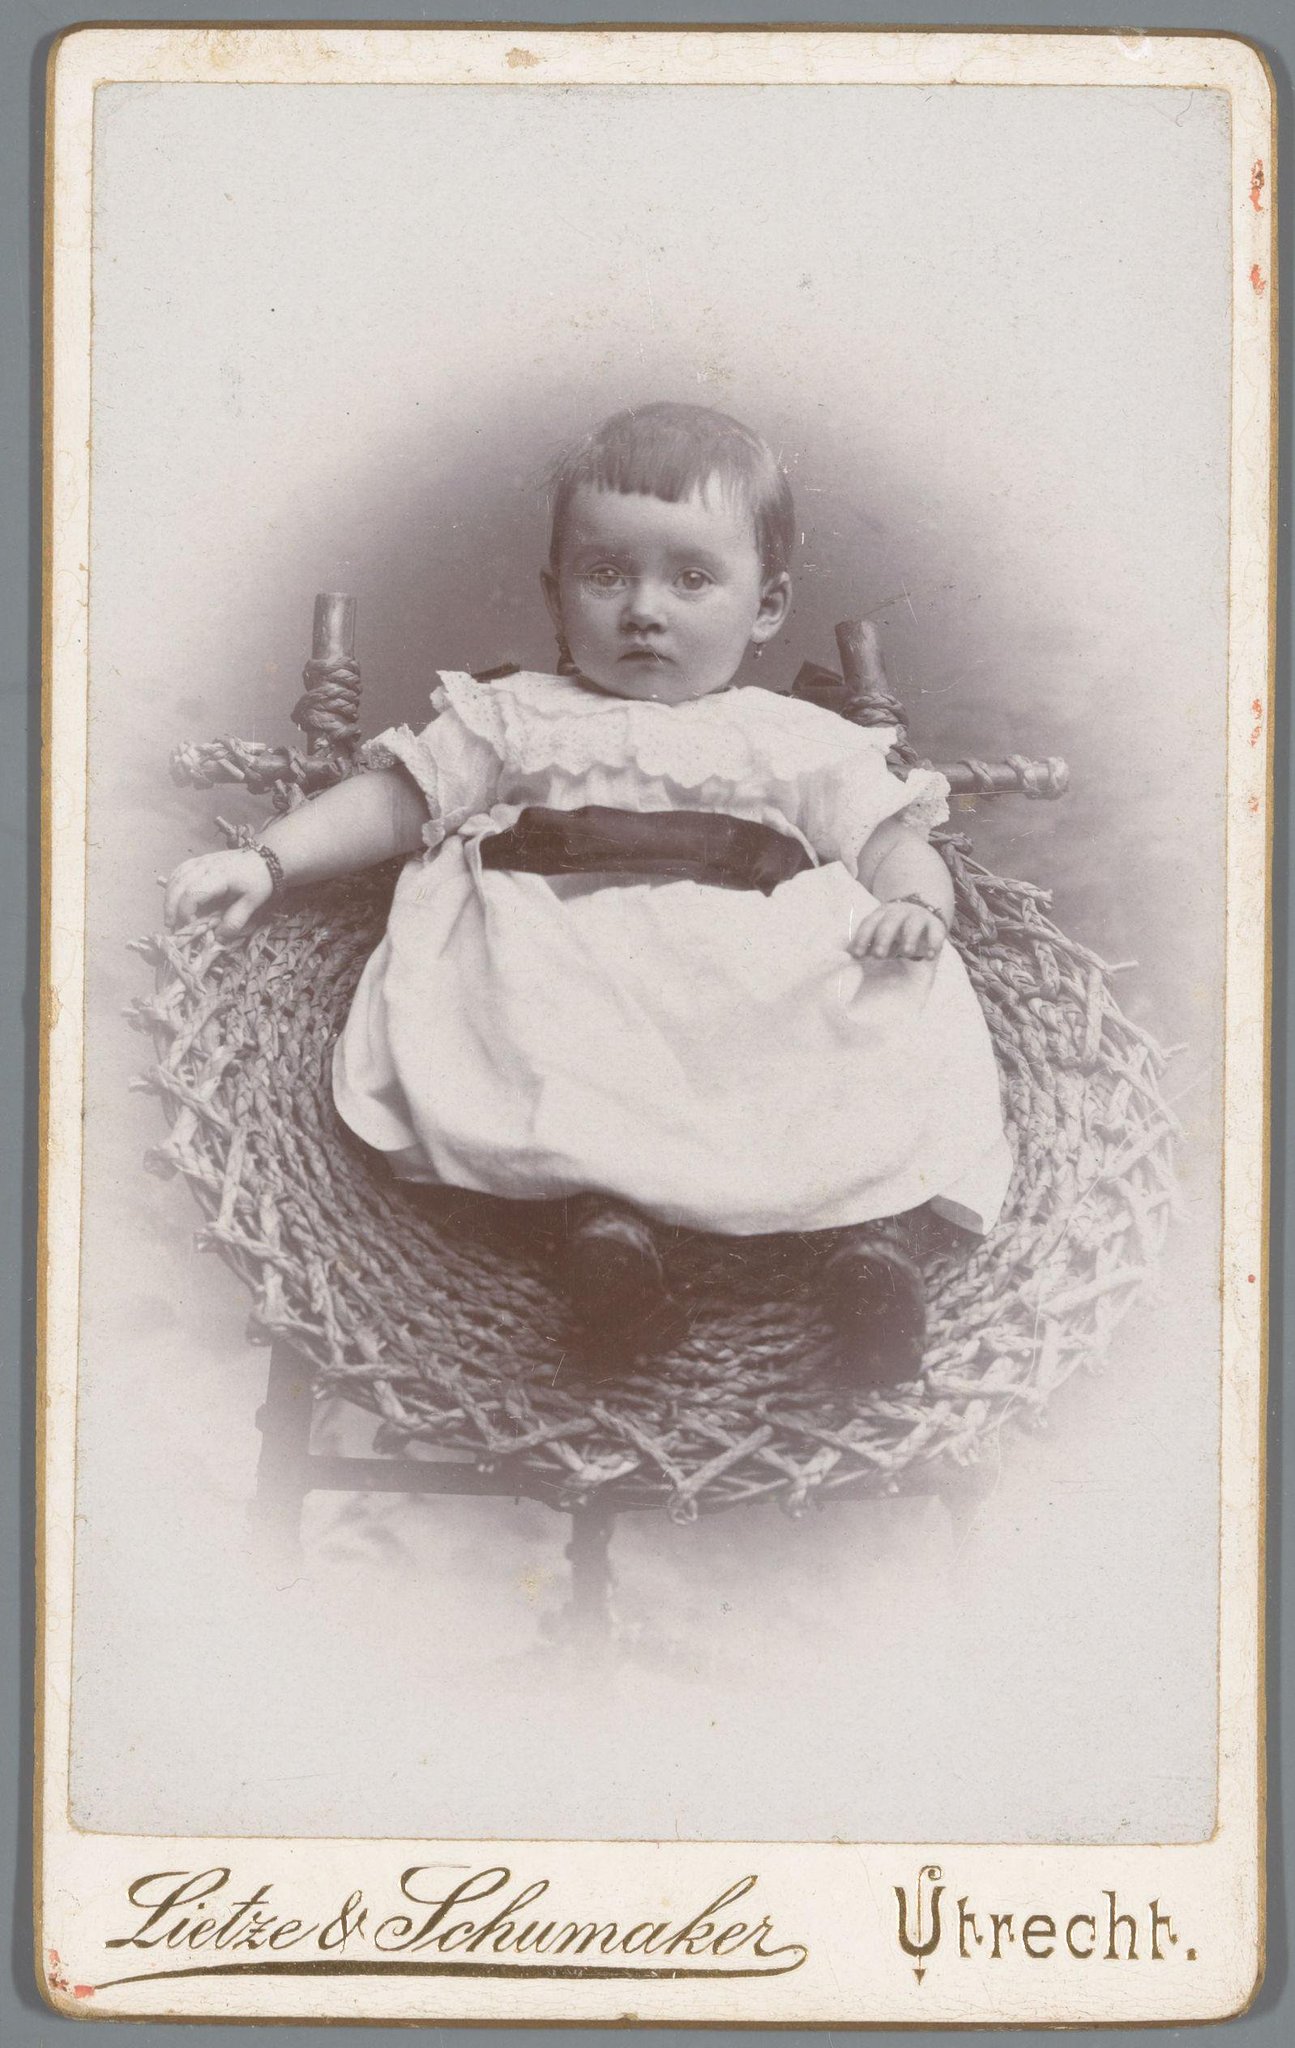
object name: photograph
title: Portret van een onbekend kind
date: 1890-1904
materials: cardboard, photographic support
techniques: collodion silver print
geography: utrecht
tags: child, historical persons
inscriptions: inscription: ‘L&S/ Photografisch Atelier/ van/ Lietze & Schumaker/ voorheen G. L. MULDER/ van Wijckskade No. 22, Hoek Noorderstraat, UTRECHT/ De platen blijven voor nabestelling bewaard.’